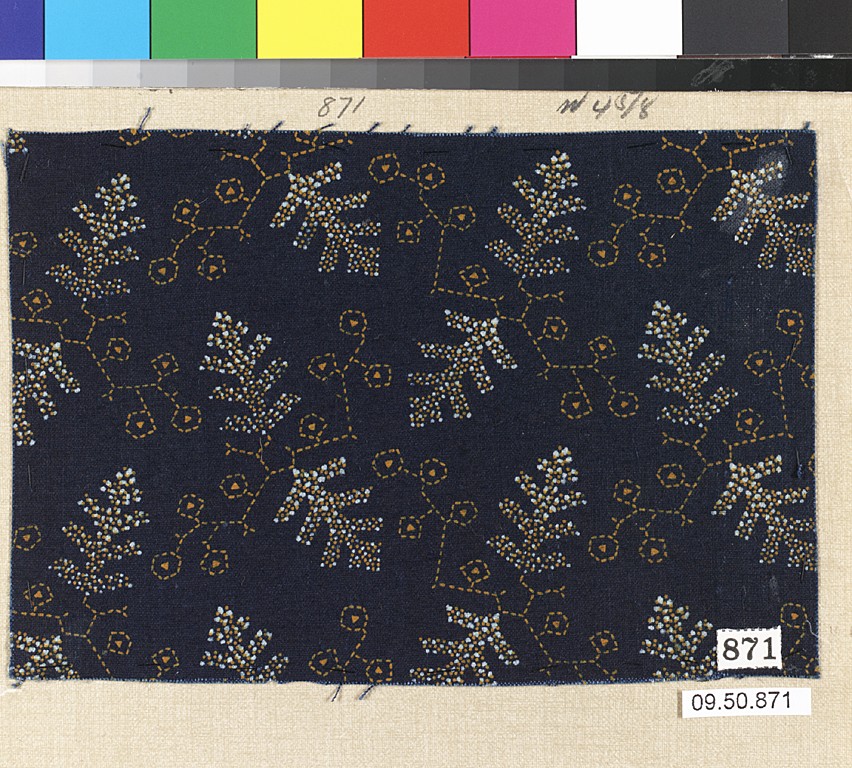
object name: piece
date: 1801-1900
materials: cotton